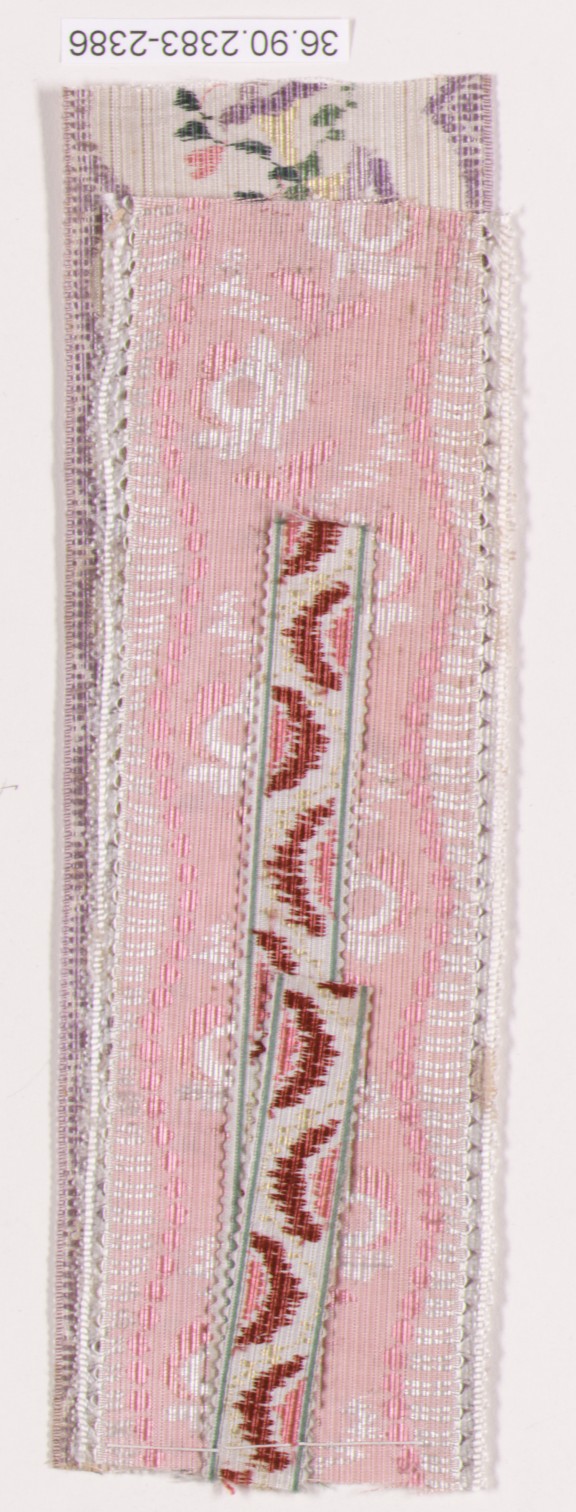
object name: ribbon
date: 1801-1900